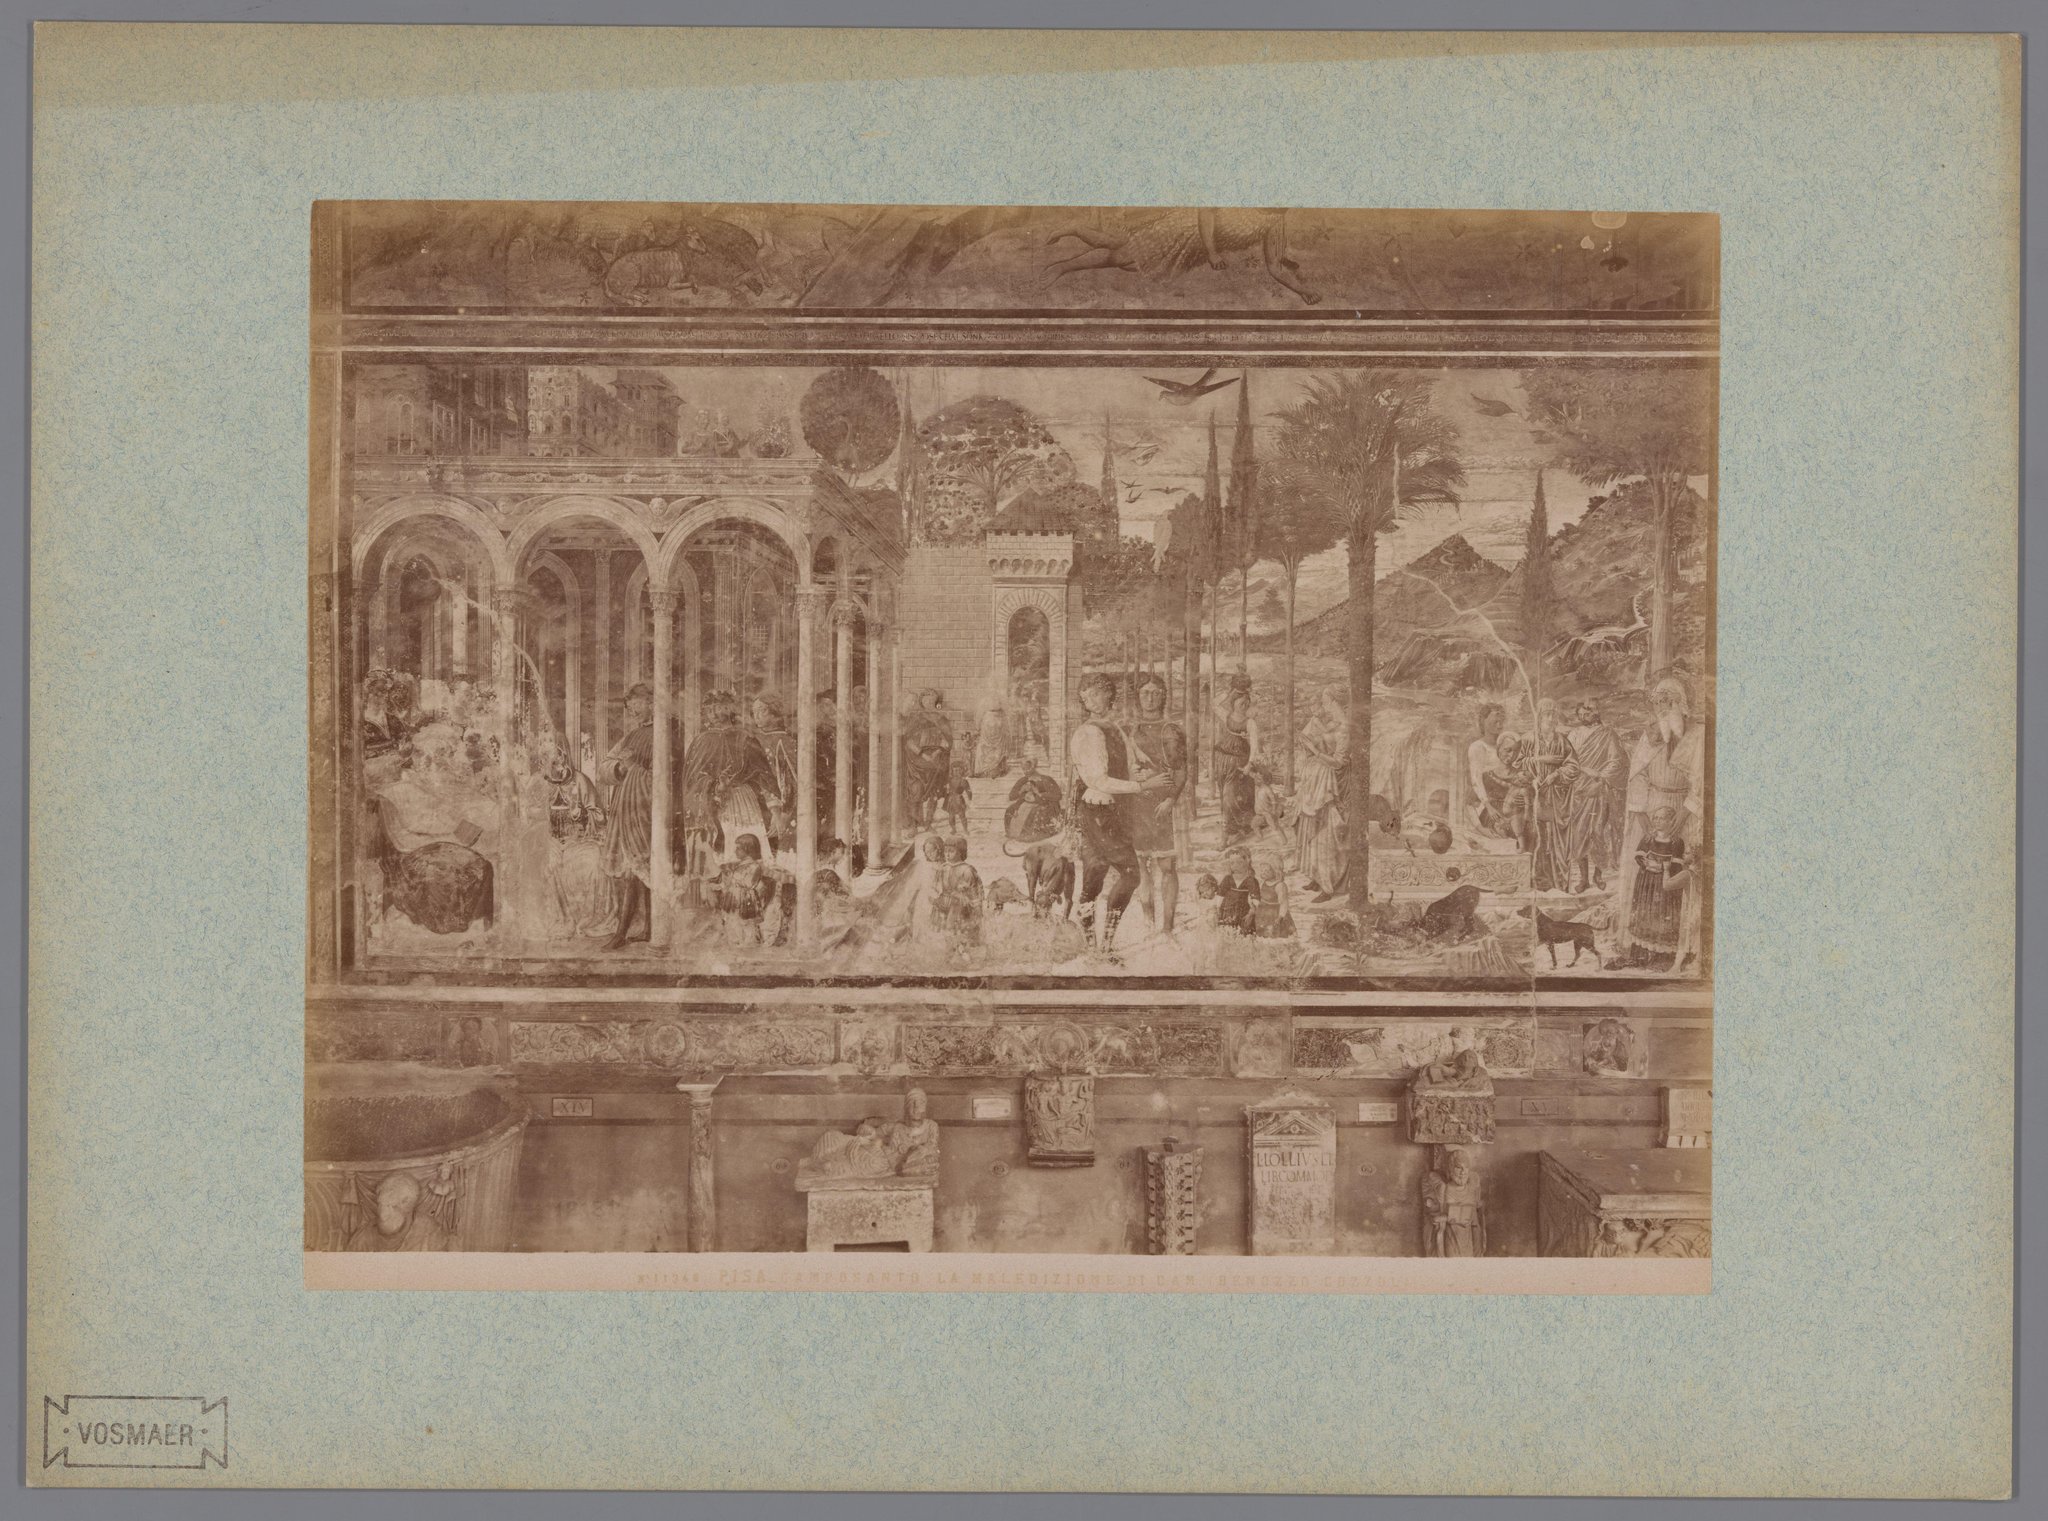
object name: photograph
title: Camposanto. La Maledizione di Cam. (Benozzo Gozzoli)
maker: benozzo gozzoli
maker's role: draughtsman, painter, sculptor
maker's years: 1421-1497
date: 1857-1900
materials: cardboard, paper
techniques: albumen print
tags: picture, painting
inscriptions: number: ‘No. 11345’, collector's mark: ‘VOSMAER’